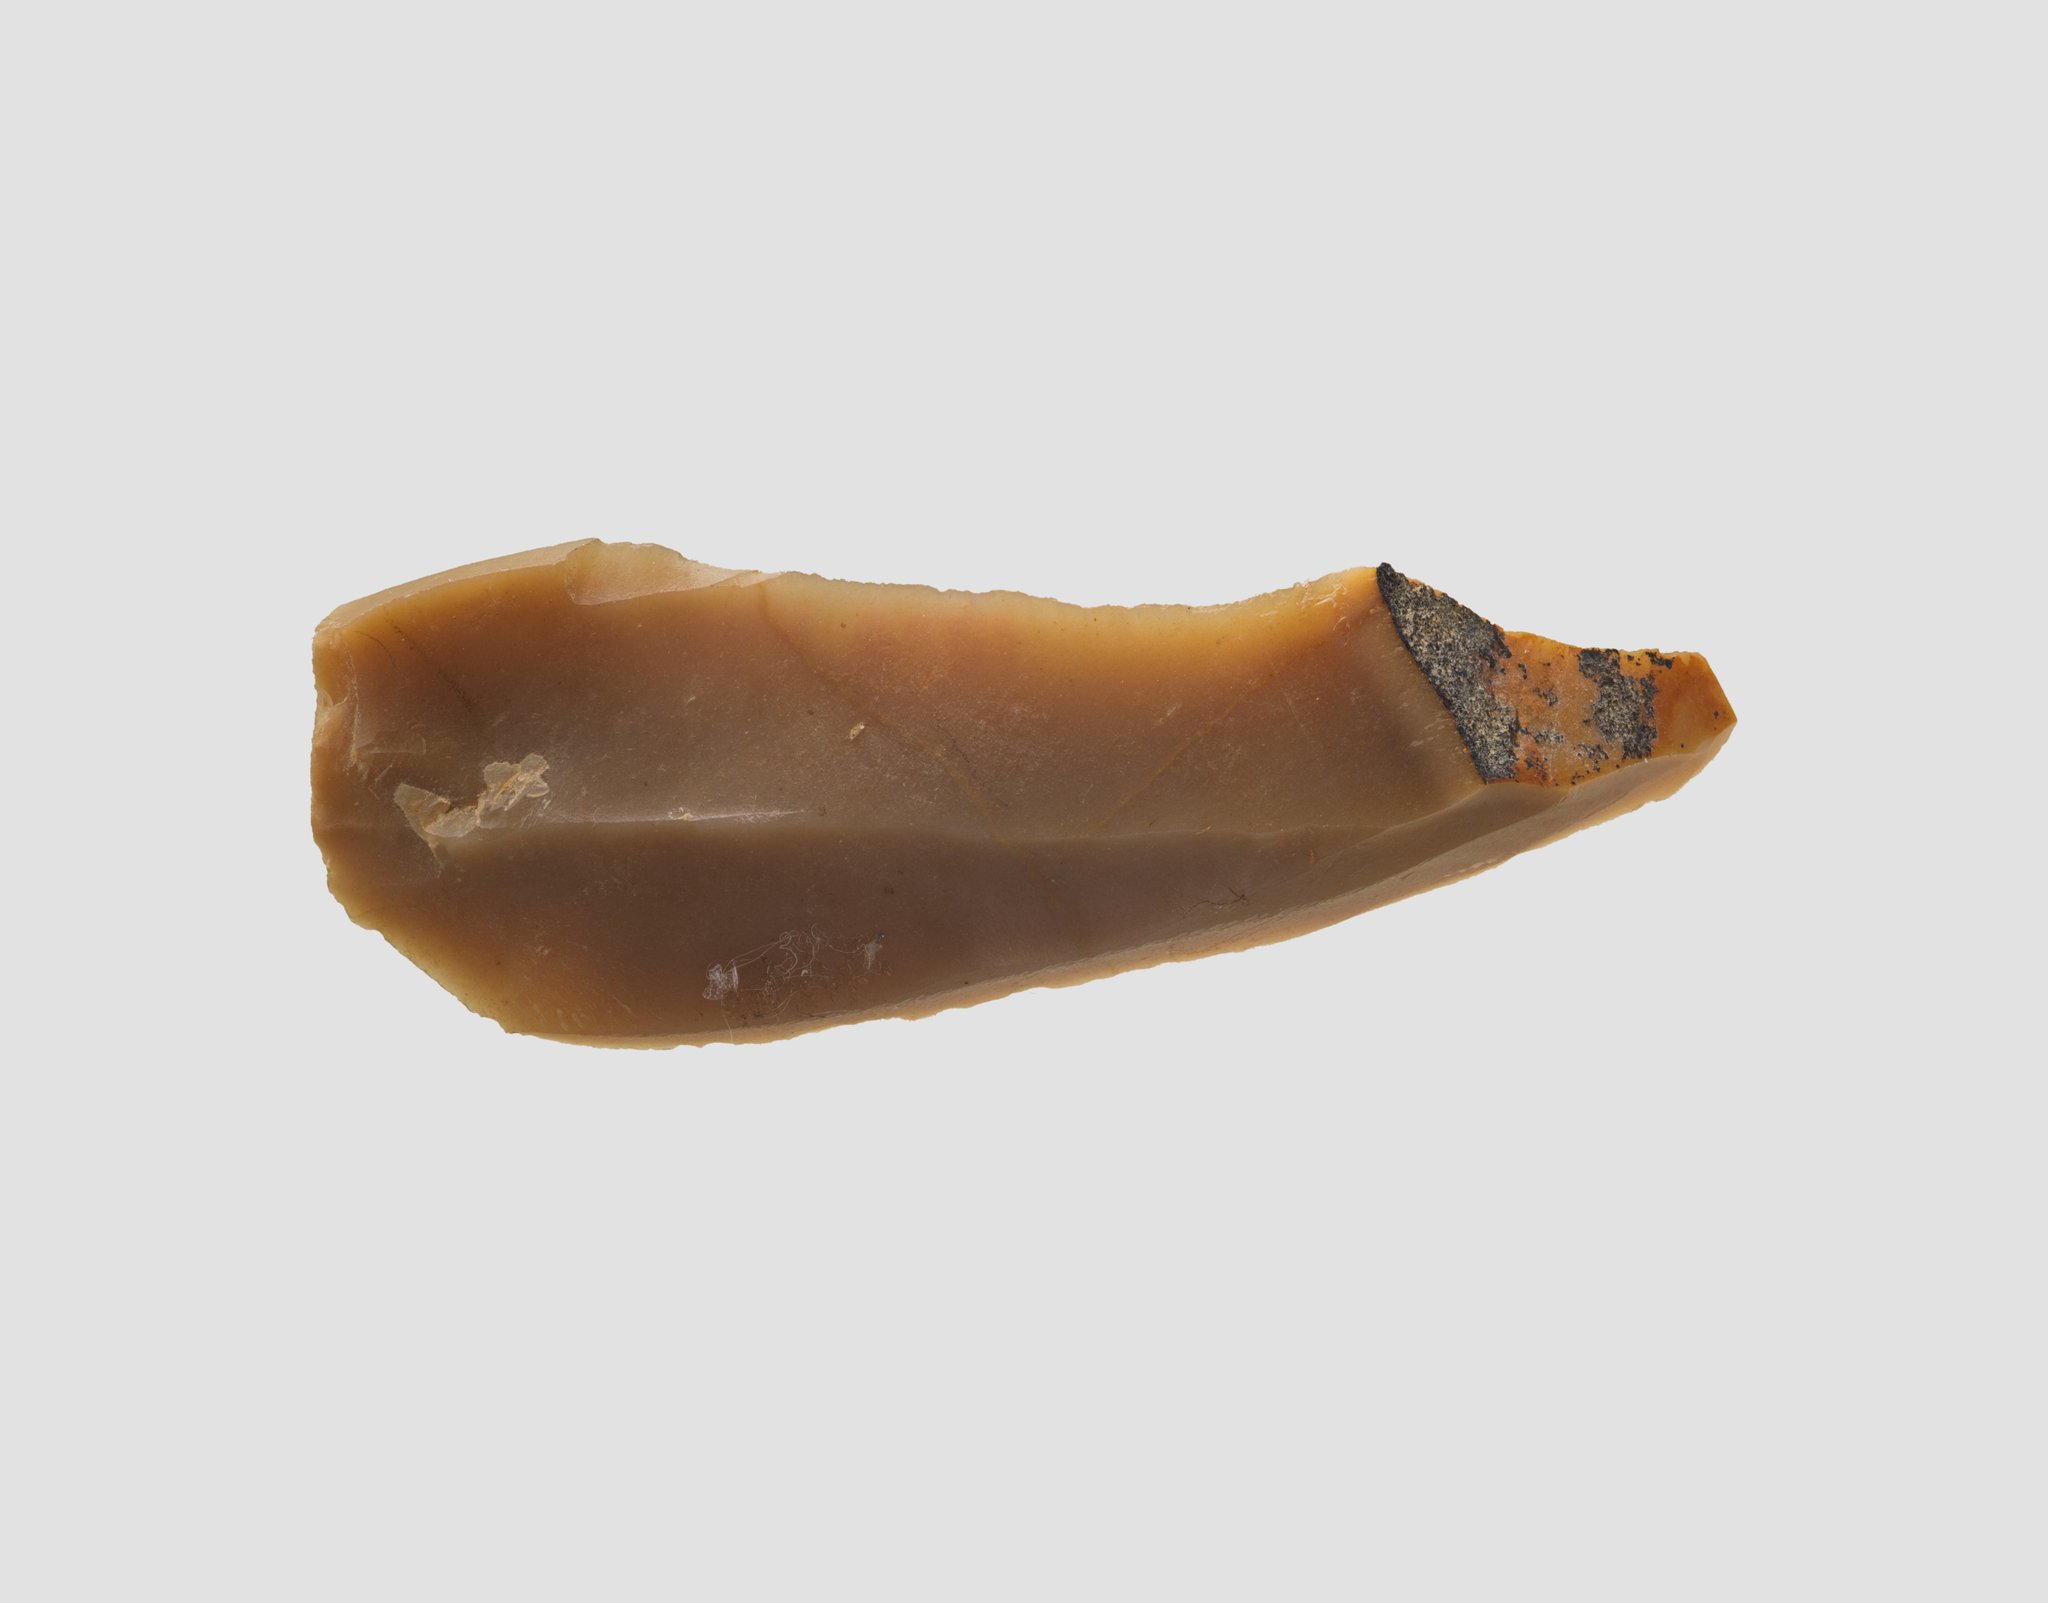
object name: knife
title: Blade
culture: ghassulian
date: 4600-3600 BCE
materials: stone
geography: levant